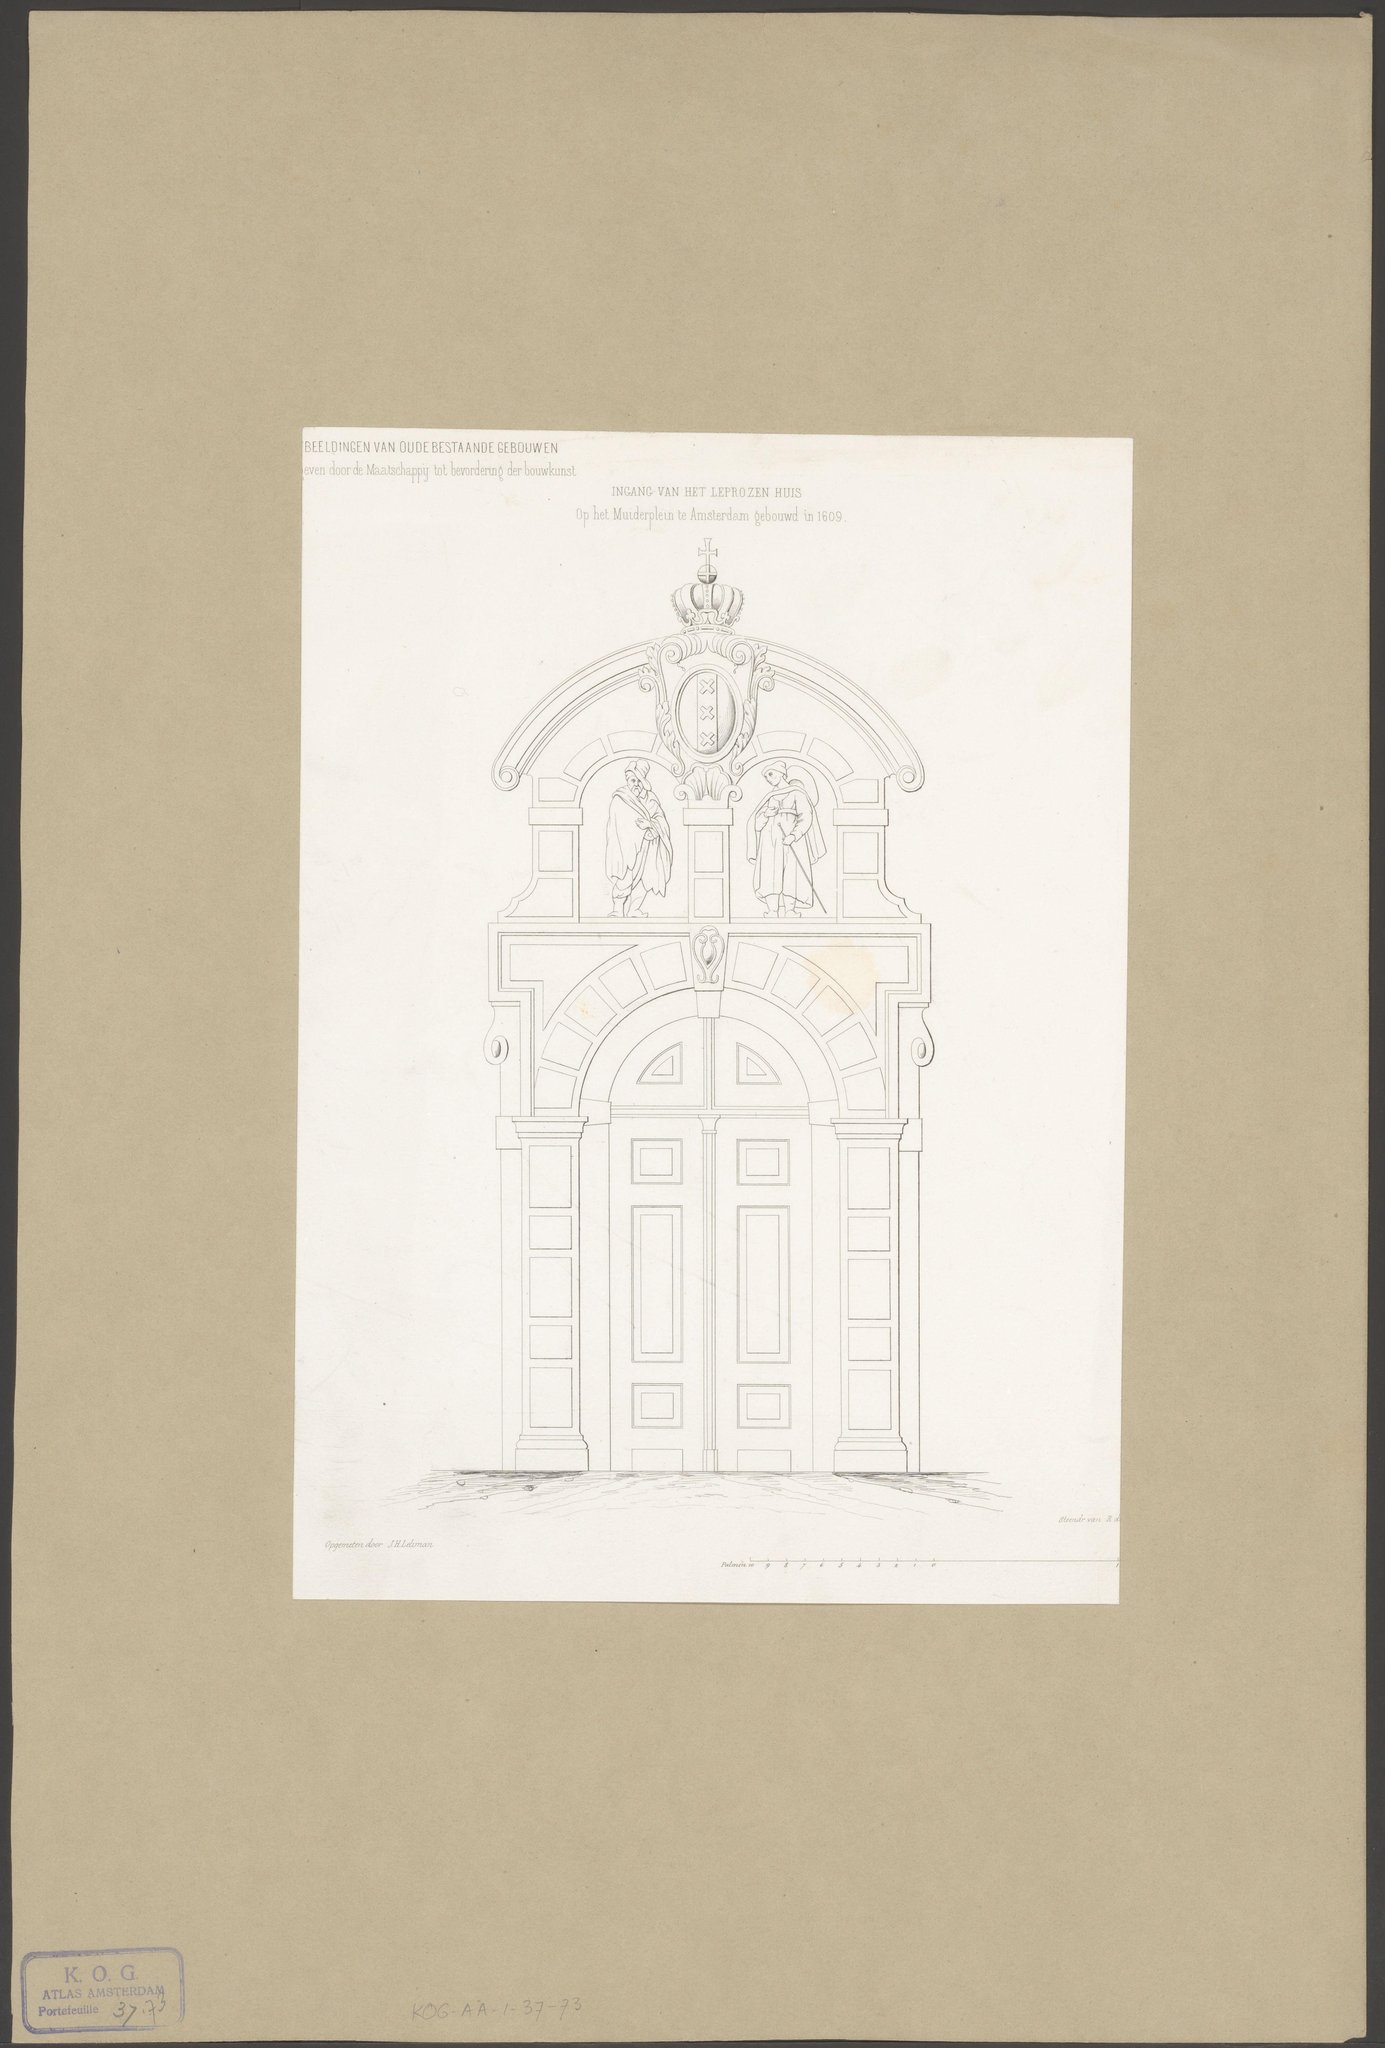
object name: print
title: Ingang van het Leprozen Huis Op het Muiderplein te Amsterdam gebouwd in 1609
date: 1860-1875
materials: paper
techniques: lithograph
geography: netherlands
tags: coat of arms (as symbol of the state, etc.) (+ city; municipal), leprosarium, gate, entrance, hospital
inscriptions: collector's mark: Lugt 1641b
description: Onderwerpsrubriek binnen de Atlas Amsterdam: Armwezen en liefdadige instellingen: I. Stadsinrichtingen: Leprozen- of Lazarushuis, omgang van leprozen, regenten.